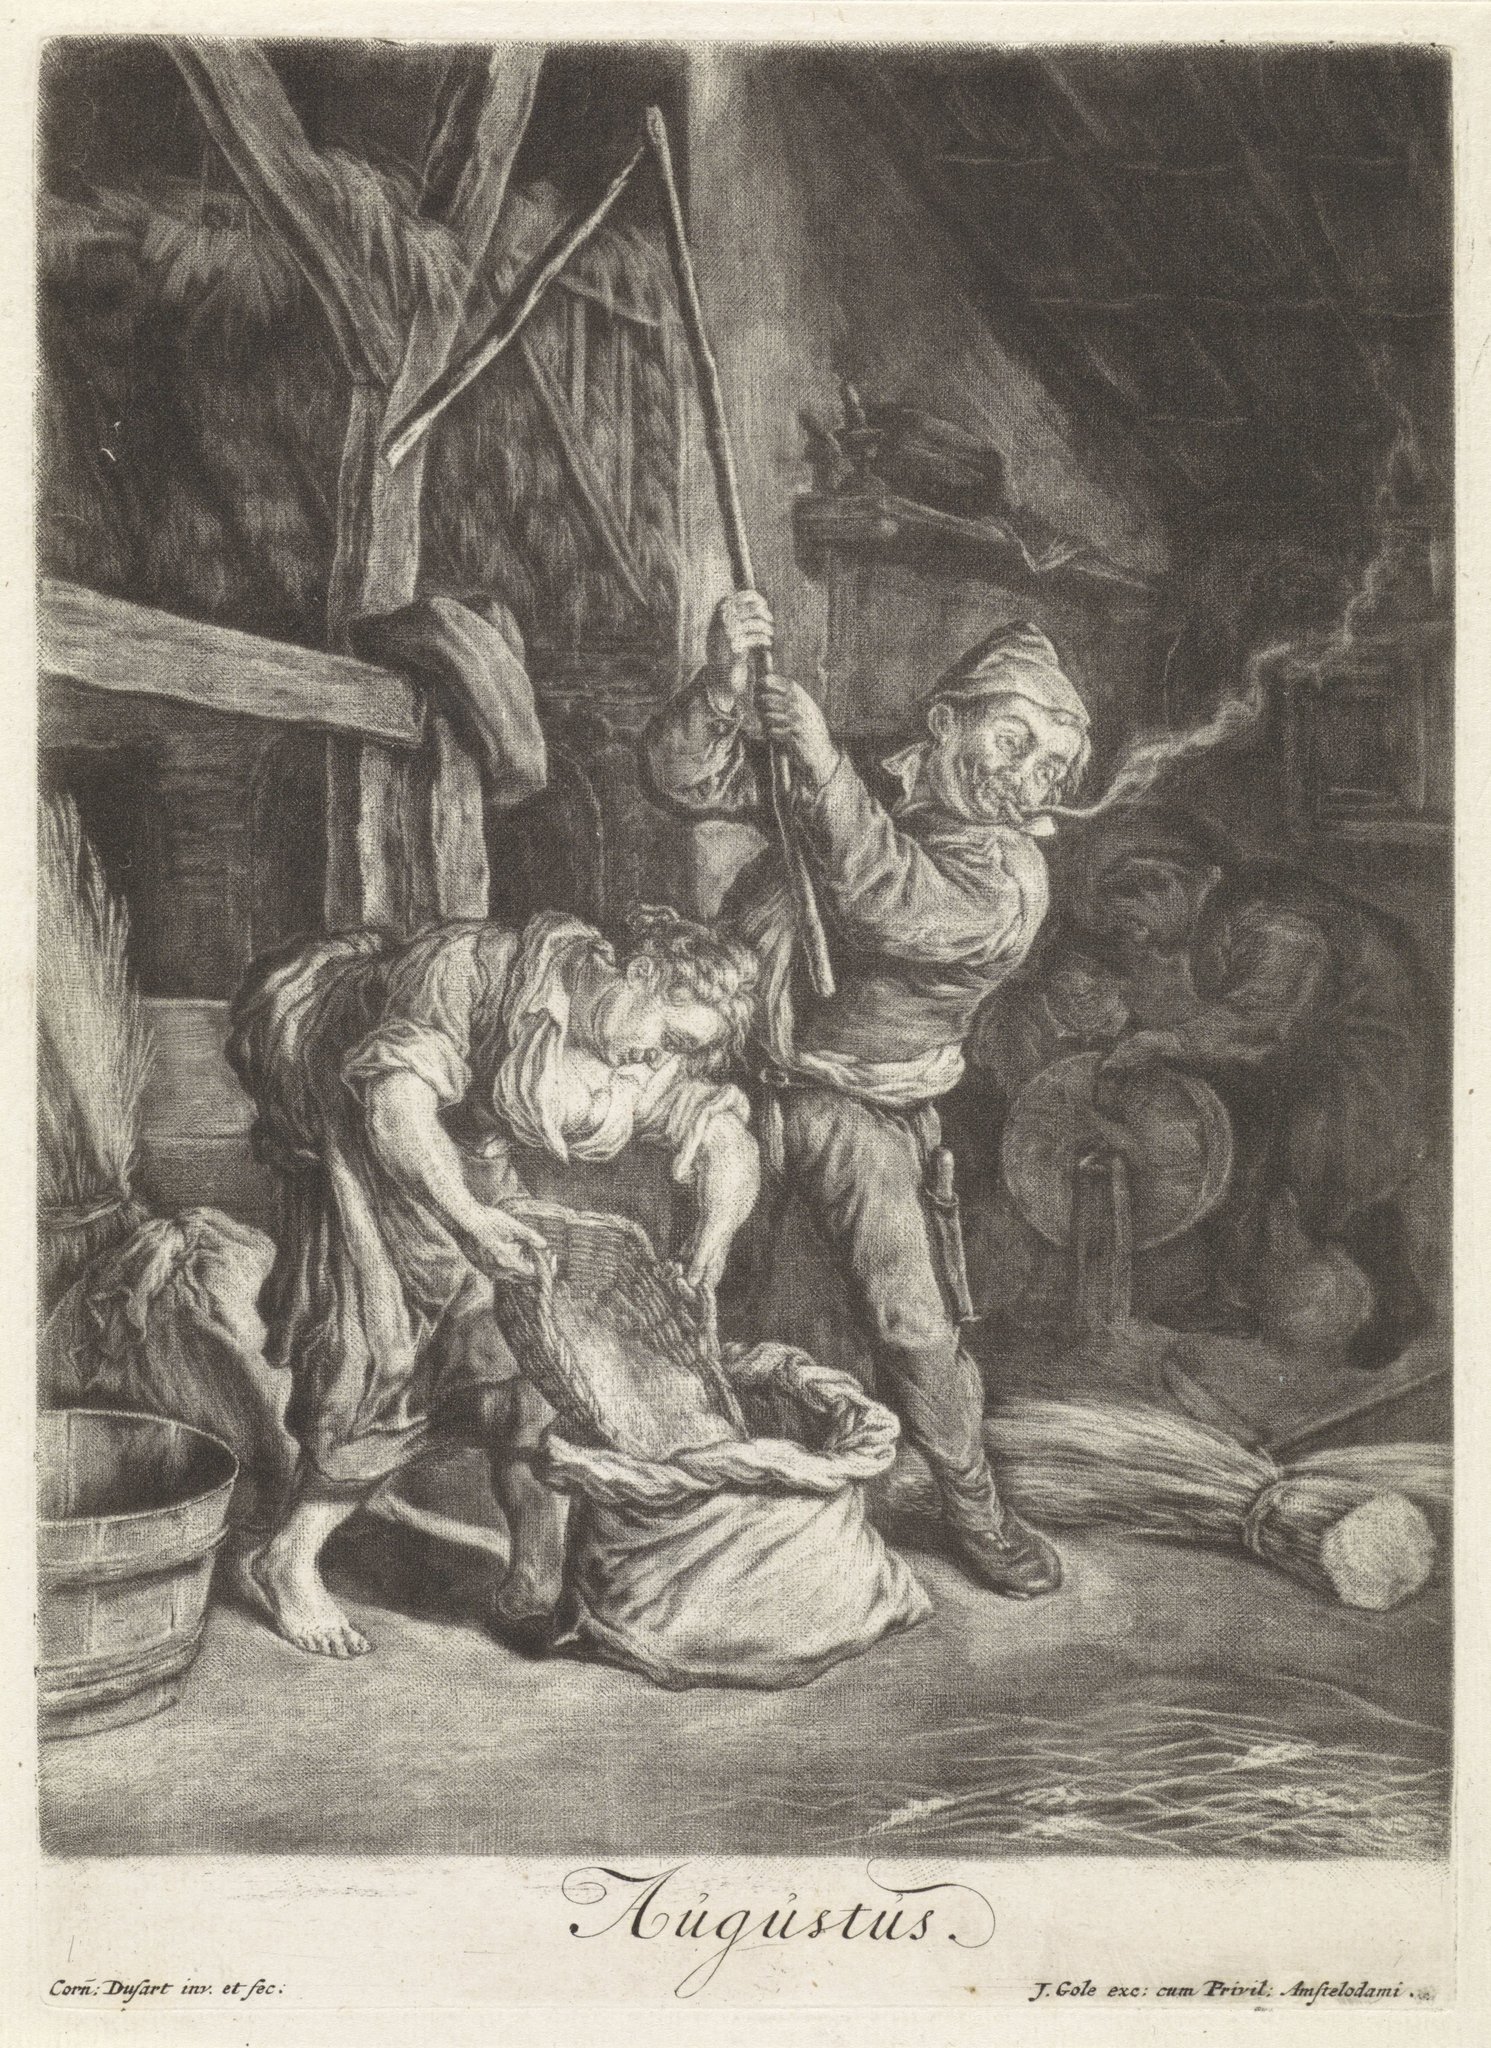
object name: print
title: Augustus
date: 1679-1704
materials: paper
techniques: engraving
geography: haarlem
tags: harvest, august and its 'labours'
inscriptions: collector's mark: Lugt 2228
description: In een schuur dorst een boer graan met een dorsvlegel. Naast hem giet een vrouw graan in een zak. Op de achtergrond twee boeren. De prent maakt deel uit van een serie van twaalf prenten met de twaalf maanden van het jaar.